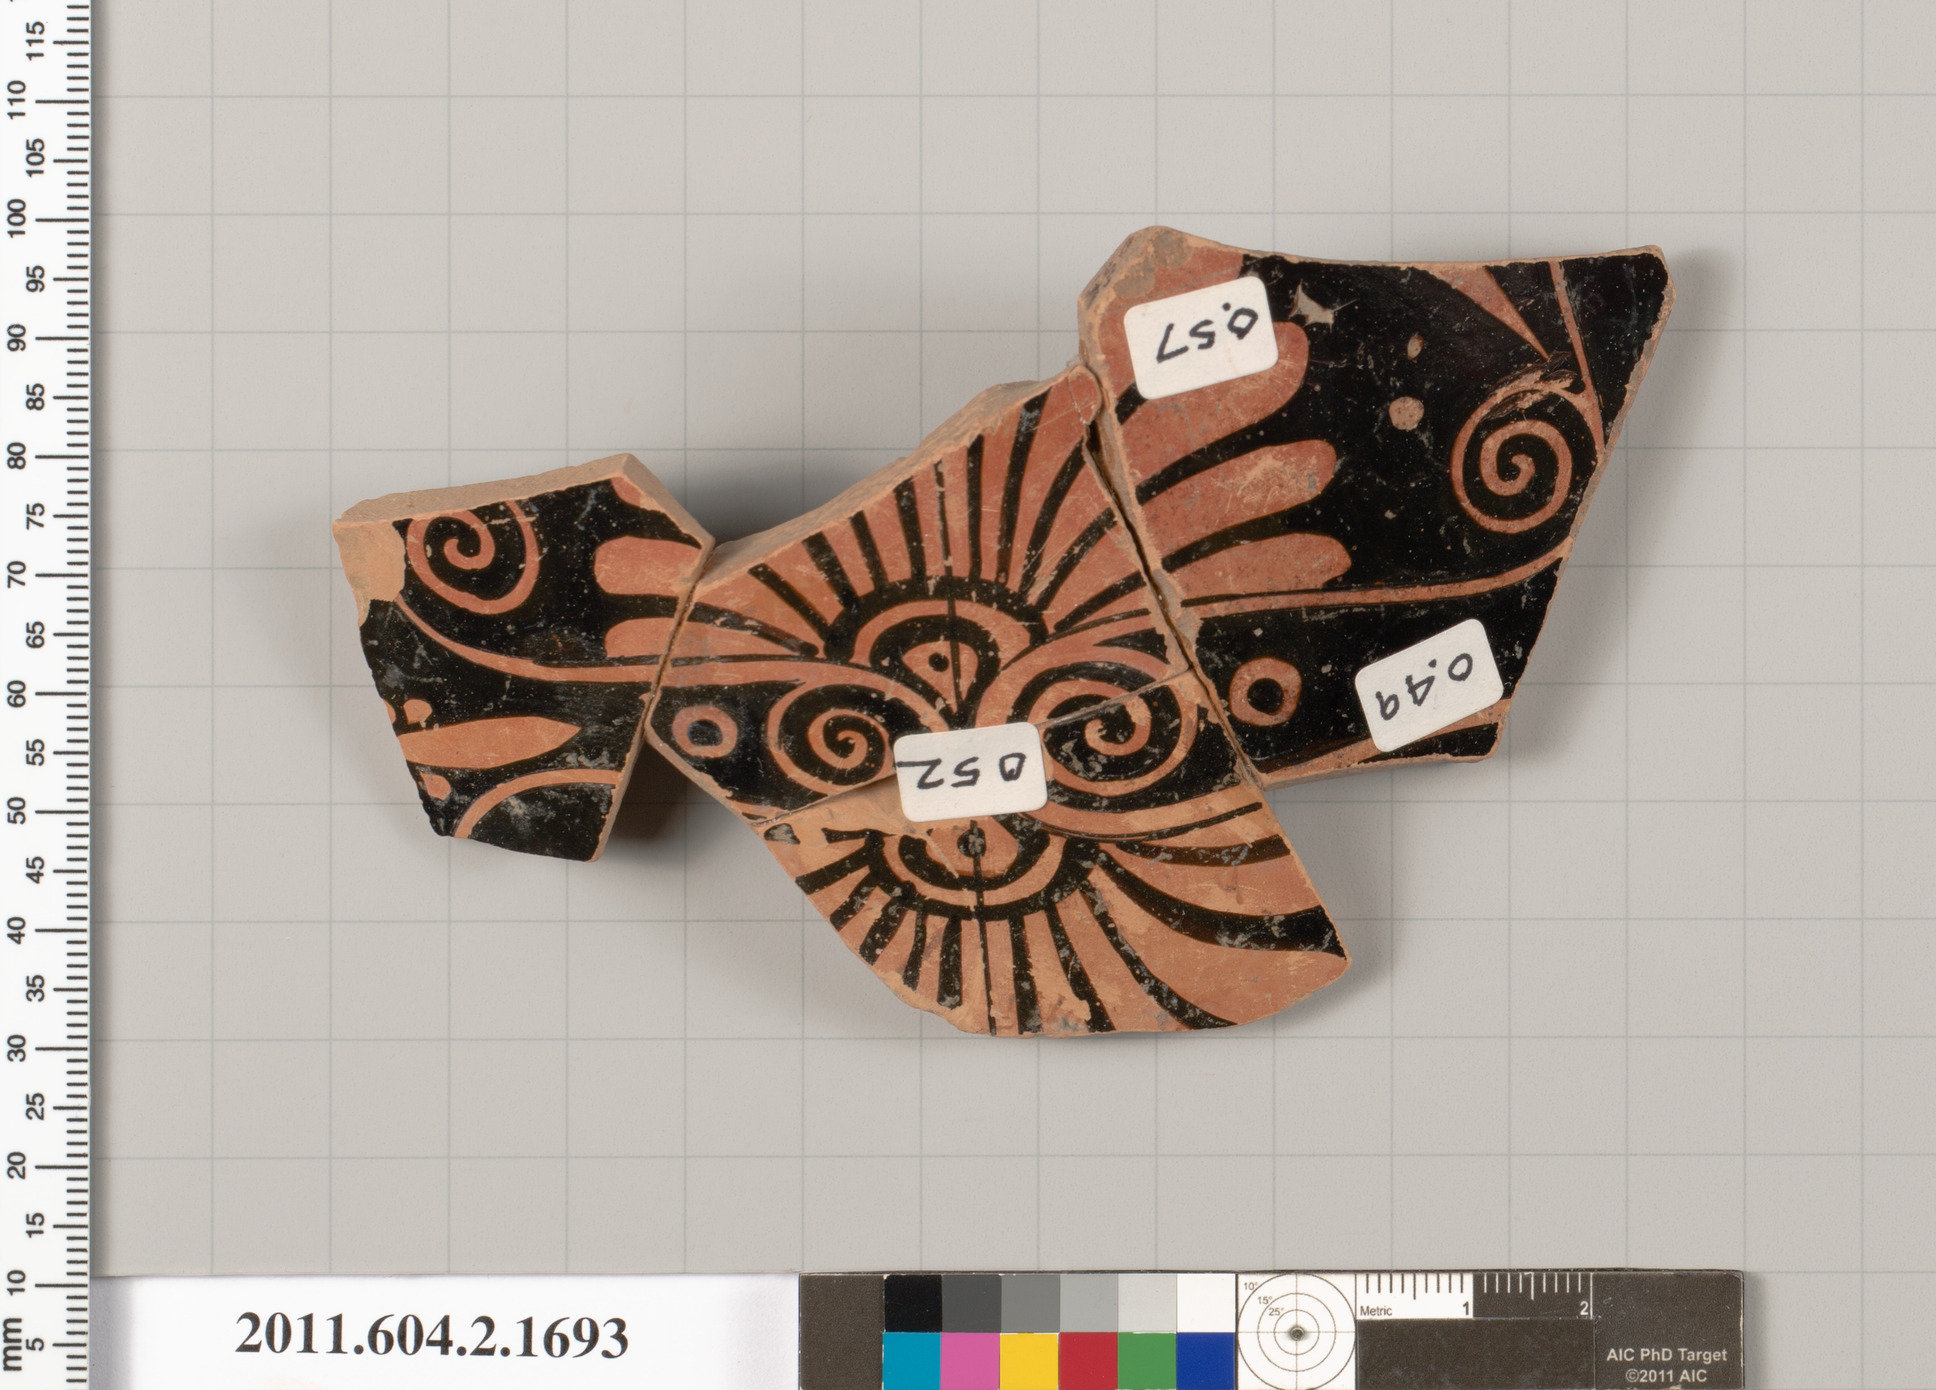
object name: skyphos fragment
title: Terracotta fragment of a skyphos (deep drinking cup)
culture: greek, attic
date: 450-440 BCE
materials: terracotta